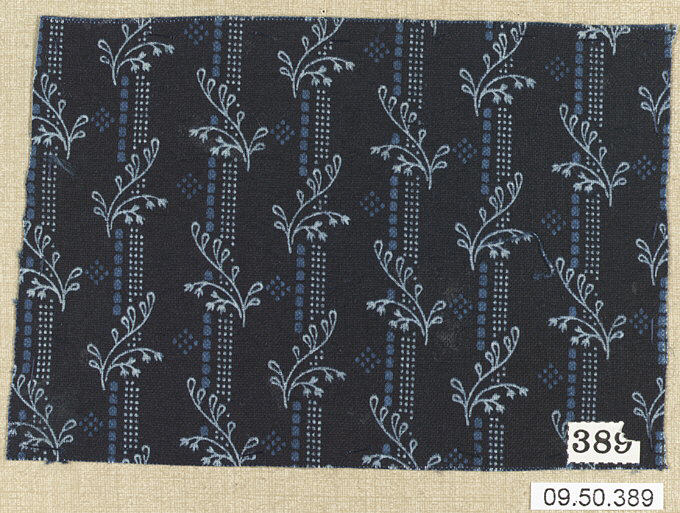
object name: piece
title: Piece (one of 116)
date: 1801-1900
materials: cotton